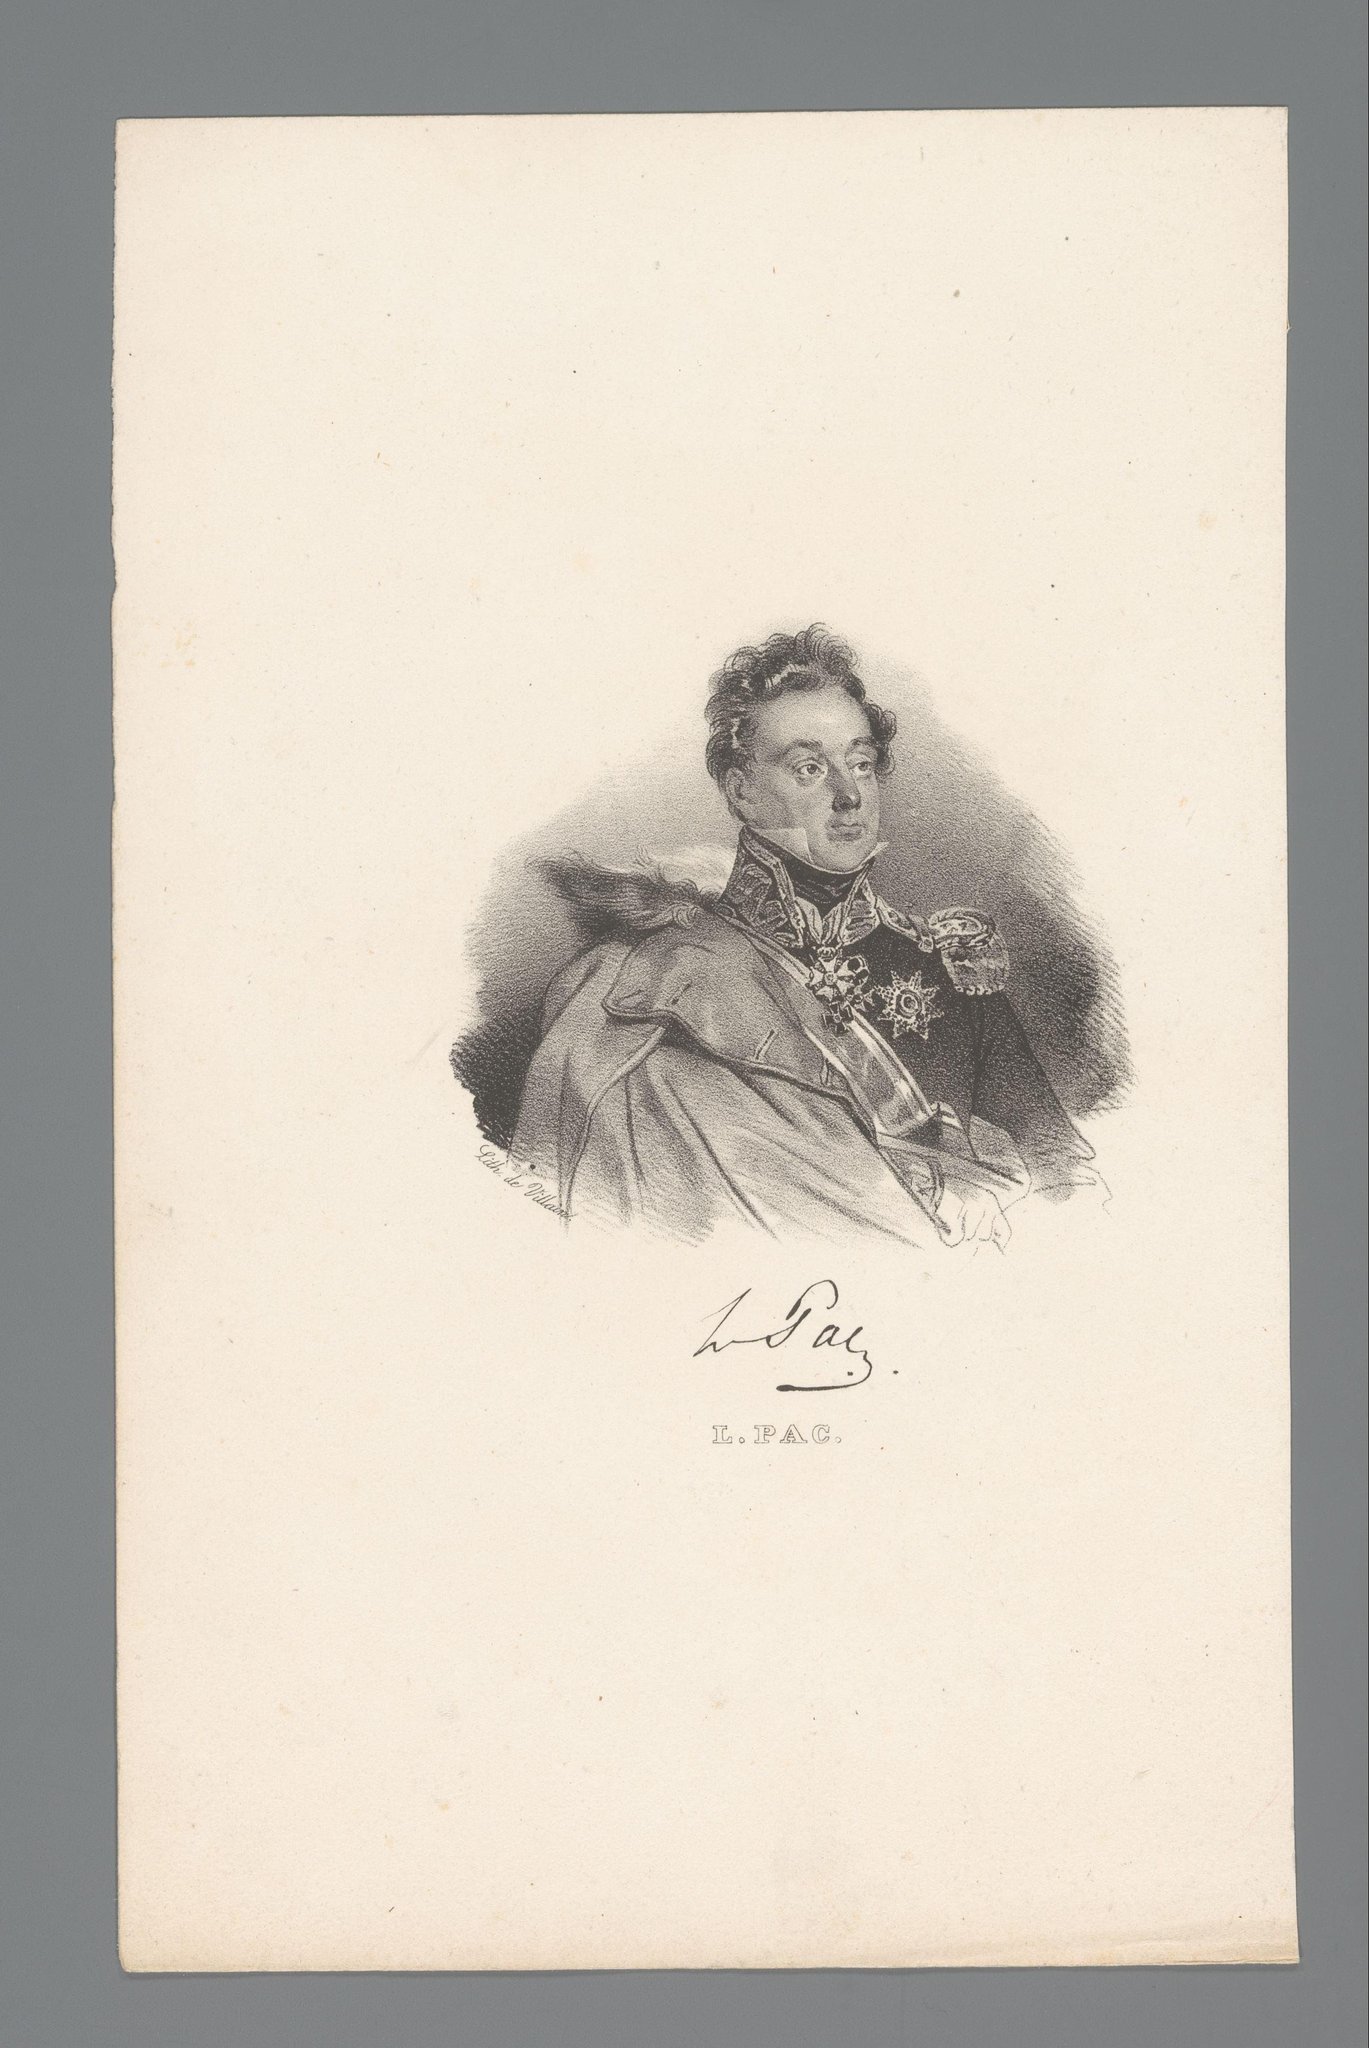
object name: book illustration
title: L. Pac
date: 1832-1839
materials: paper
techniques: lithograph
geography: paris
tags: historical persons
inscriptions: collector's mark: Lugt 2228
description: Prent uit: Straszewicz., Joseph. Les polonais et les polonaises de la révolution du 29 novembre 1830, ou Portraits des personnes qui ont figuré dans la dernière guerre de l'indépendance polonaise, avec les fac-simile de leur signature, lithographiés sur dessins originaux, par les artistes les plus distingués: MM. Grévedon, Maurin, Vigneron, Belliard, Devéria, Bazin, Desmadryl, Lecler, Desmaisons, Rutowski, officier polonais, etc,. etc., accompagnés d'une biographie pour chaque portrait. Parijs: Catherine-Anaïs Pinard, 1832. Of uit: Straszewicz., Joseph. Les polonais et les polonaises de la révolution du 29 novembre 1830. Biographie des personnes qui ont figuré dans la dernière guerre de l'indépendance polonaise, avec les fac-simile de leur signature, ornée de 30 portraits lithographiés sur dessins originaux, par les artistes les plus distingués: MM. Grévedon, Maurin, Vigneron, Belliard, Devéria, Bazin, Desmadryl, Lecler, etc., etc.. Parijs: s.n., 1839.